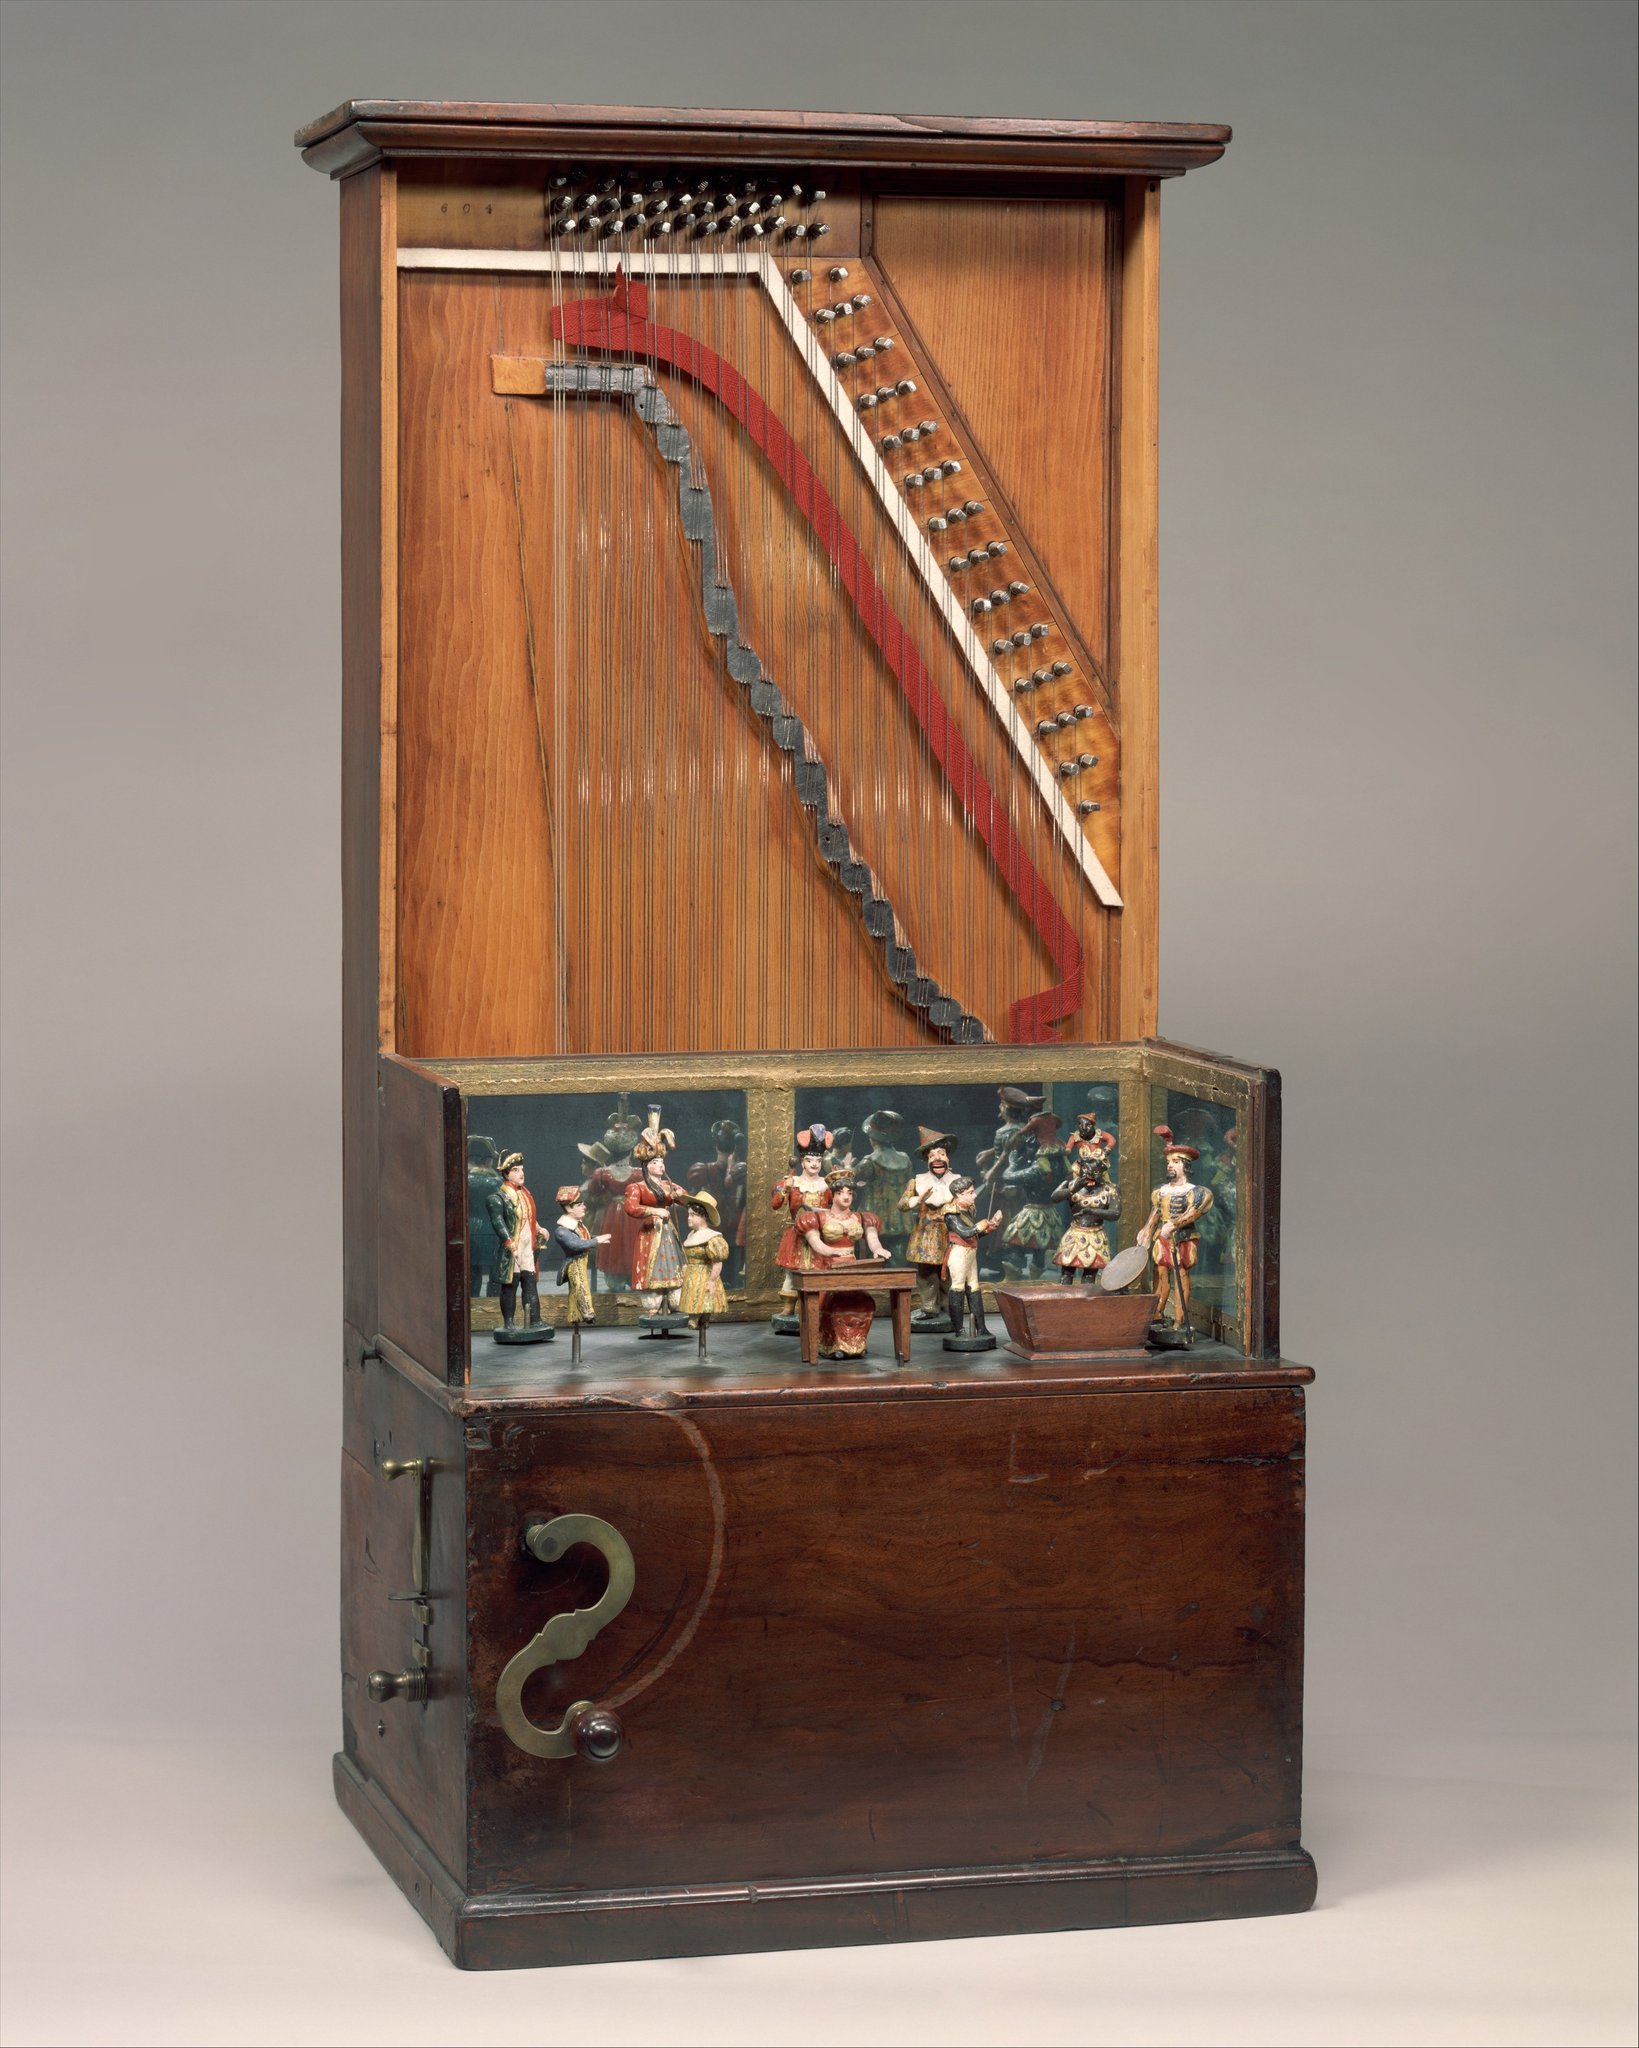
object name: barrel piano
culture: american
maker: george hicks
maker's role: maker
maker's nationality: british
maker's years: 1818-1863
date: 1860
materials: wood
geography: united states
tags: men,women